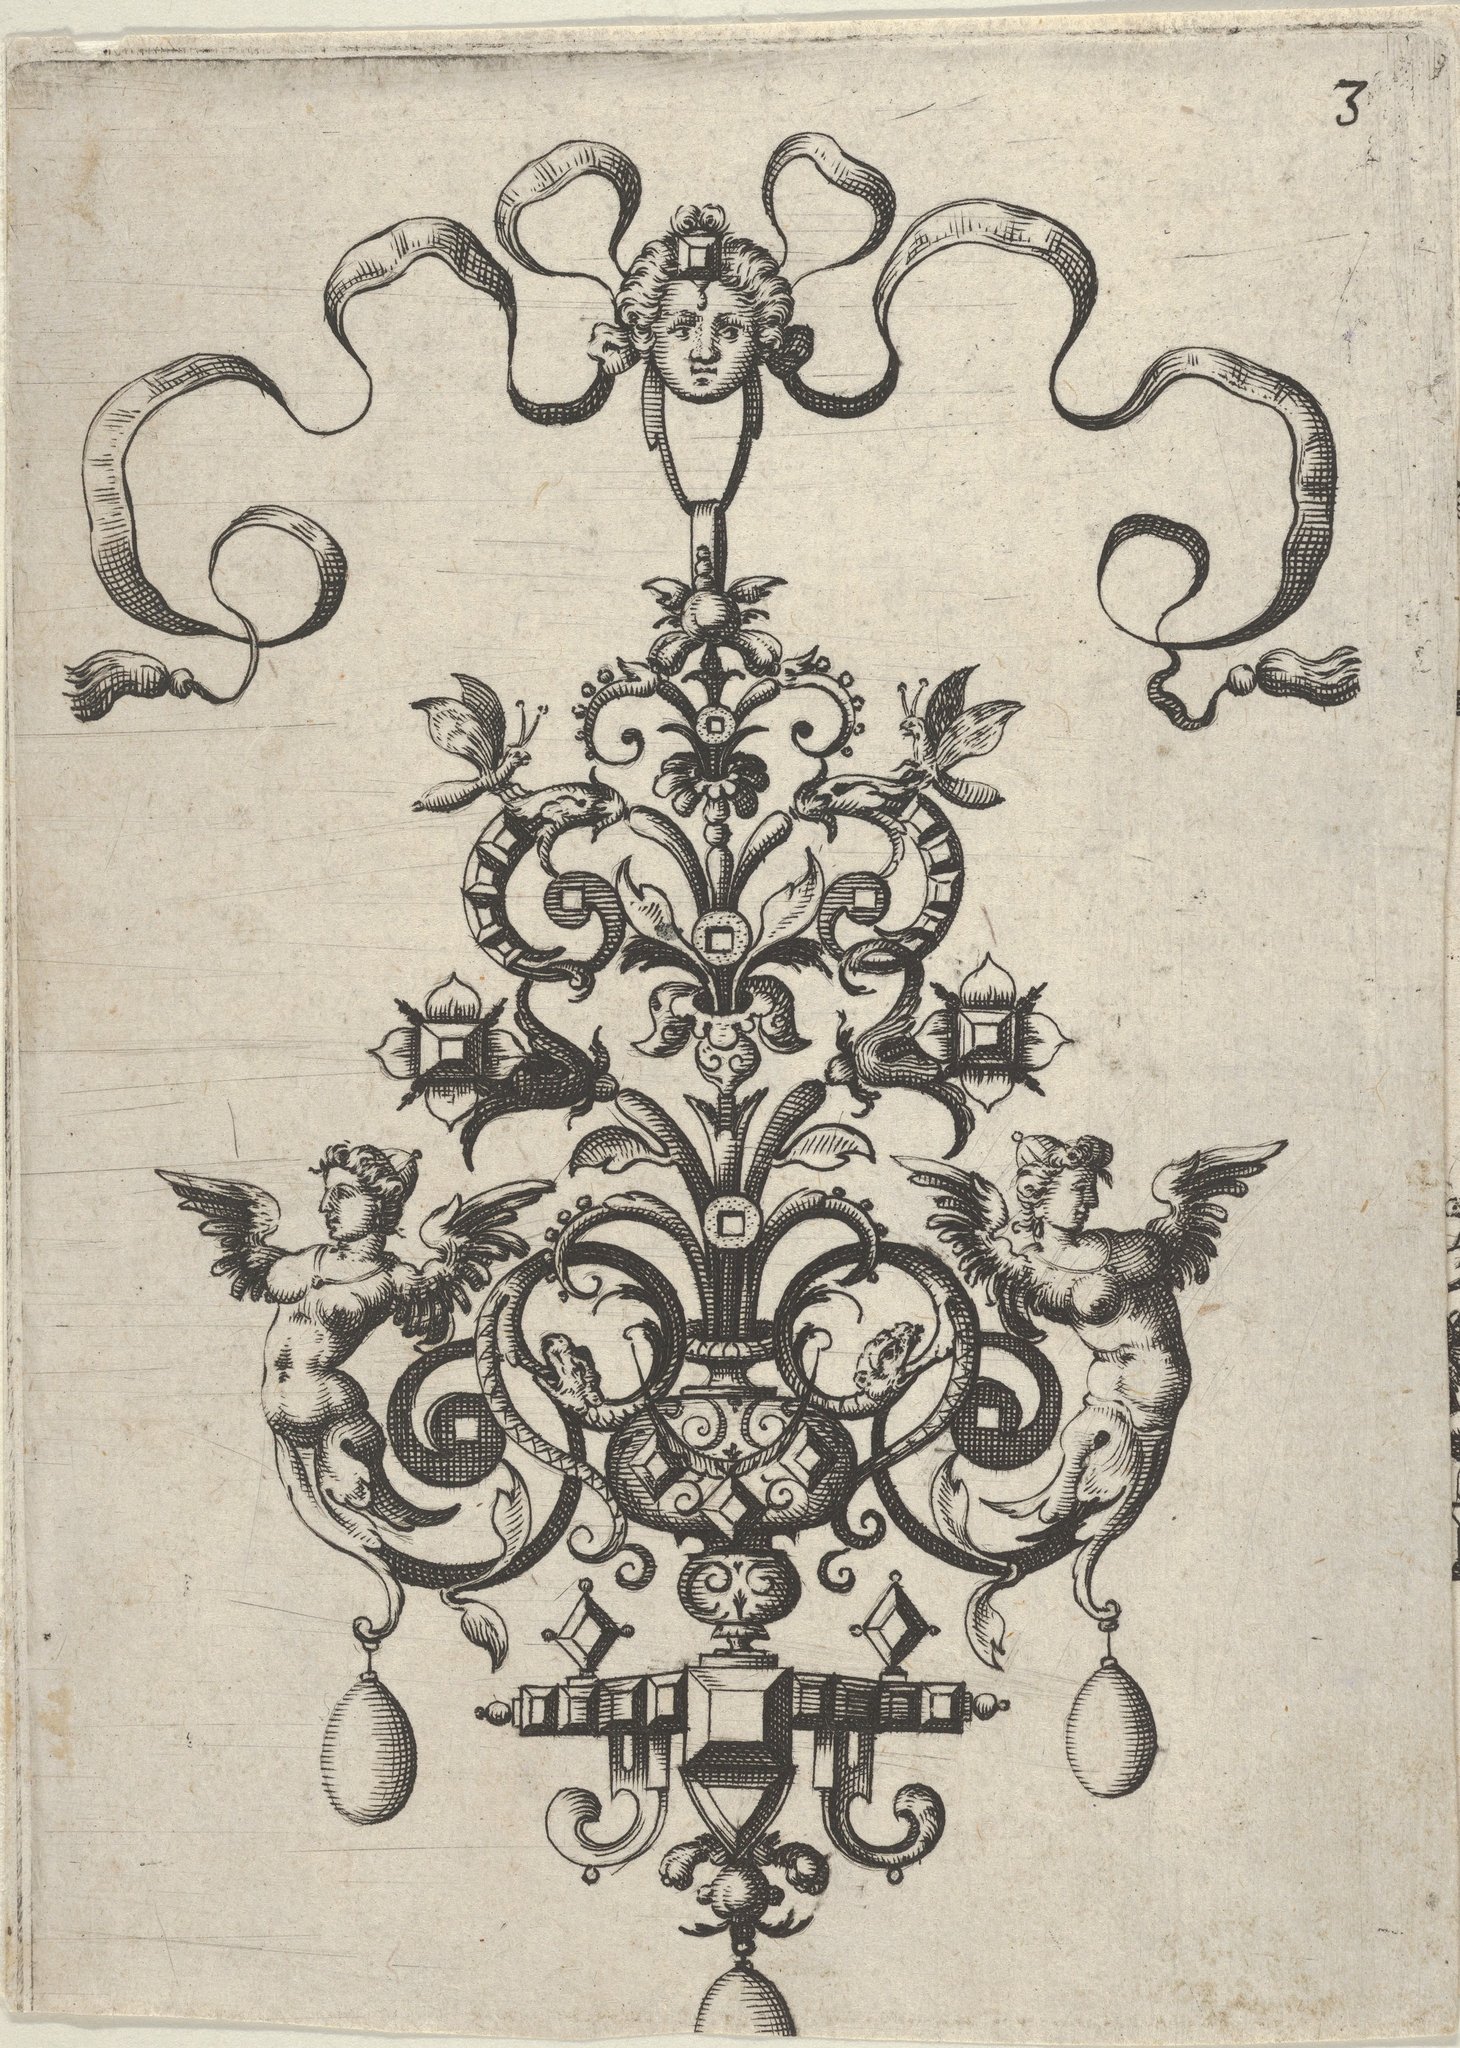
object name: print ornament architecture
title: Reverse Copy of Design for a Pendant, from Ars His Myronis Nobilis Effingitus Pagellulis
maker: paul birckenhultz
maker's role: artist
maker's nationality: german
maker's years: 1561-1639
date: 1600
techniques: engraving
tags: pendants